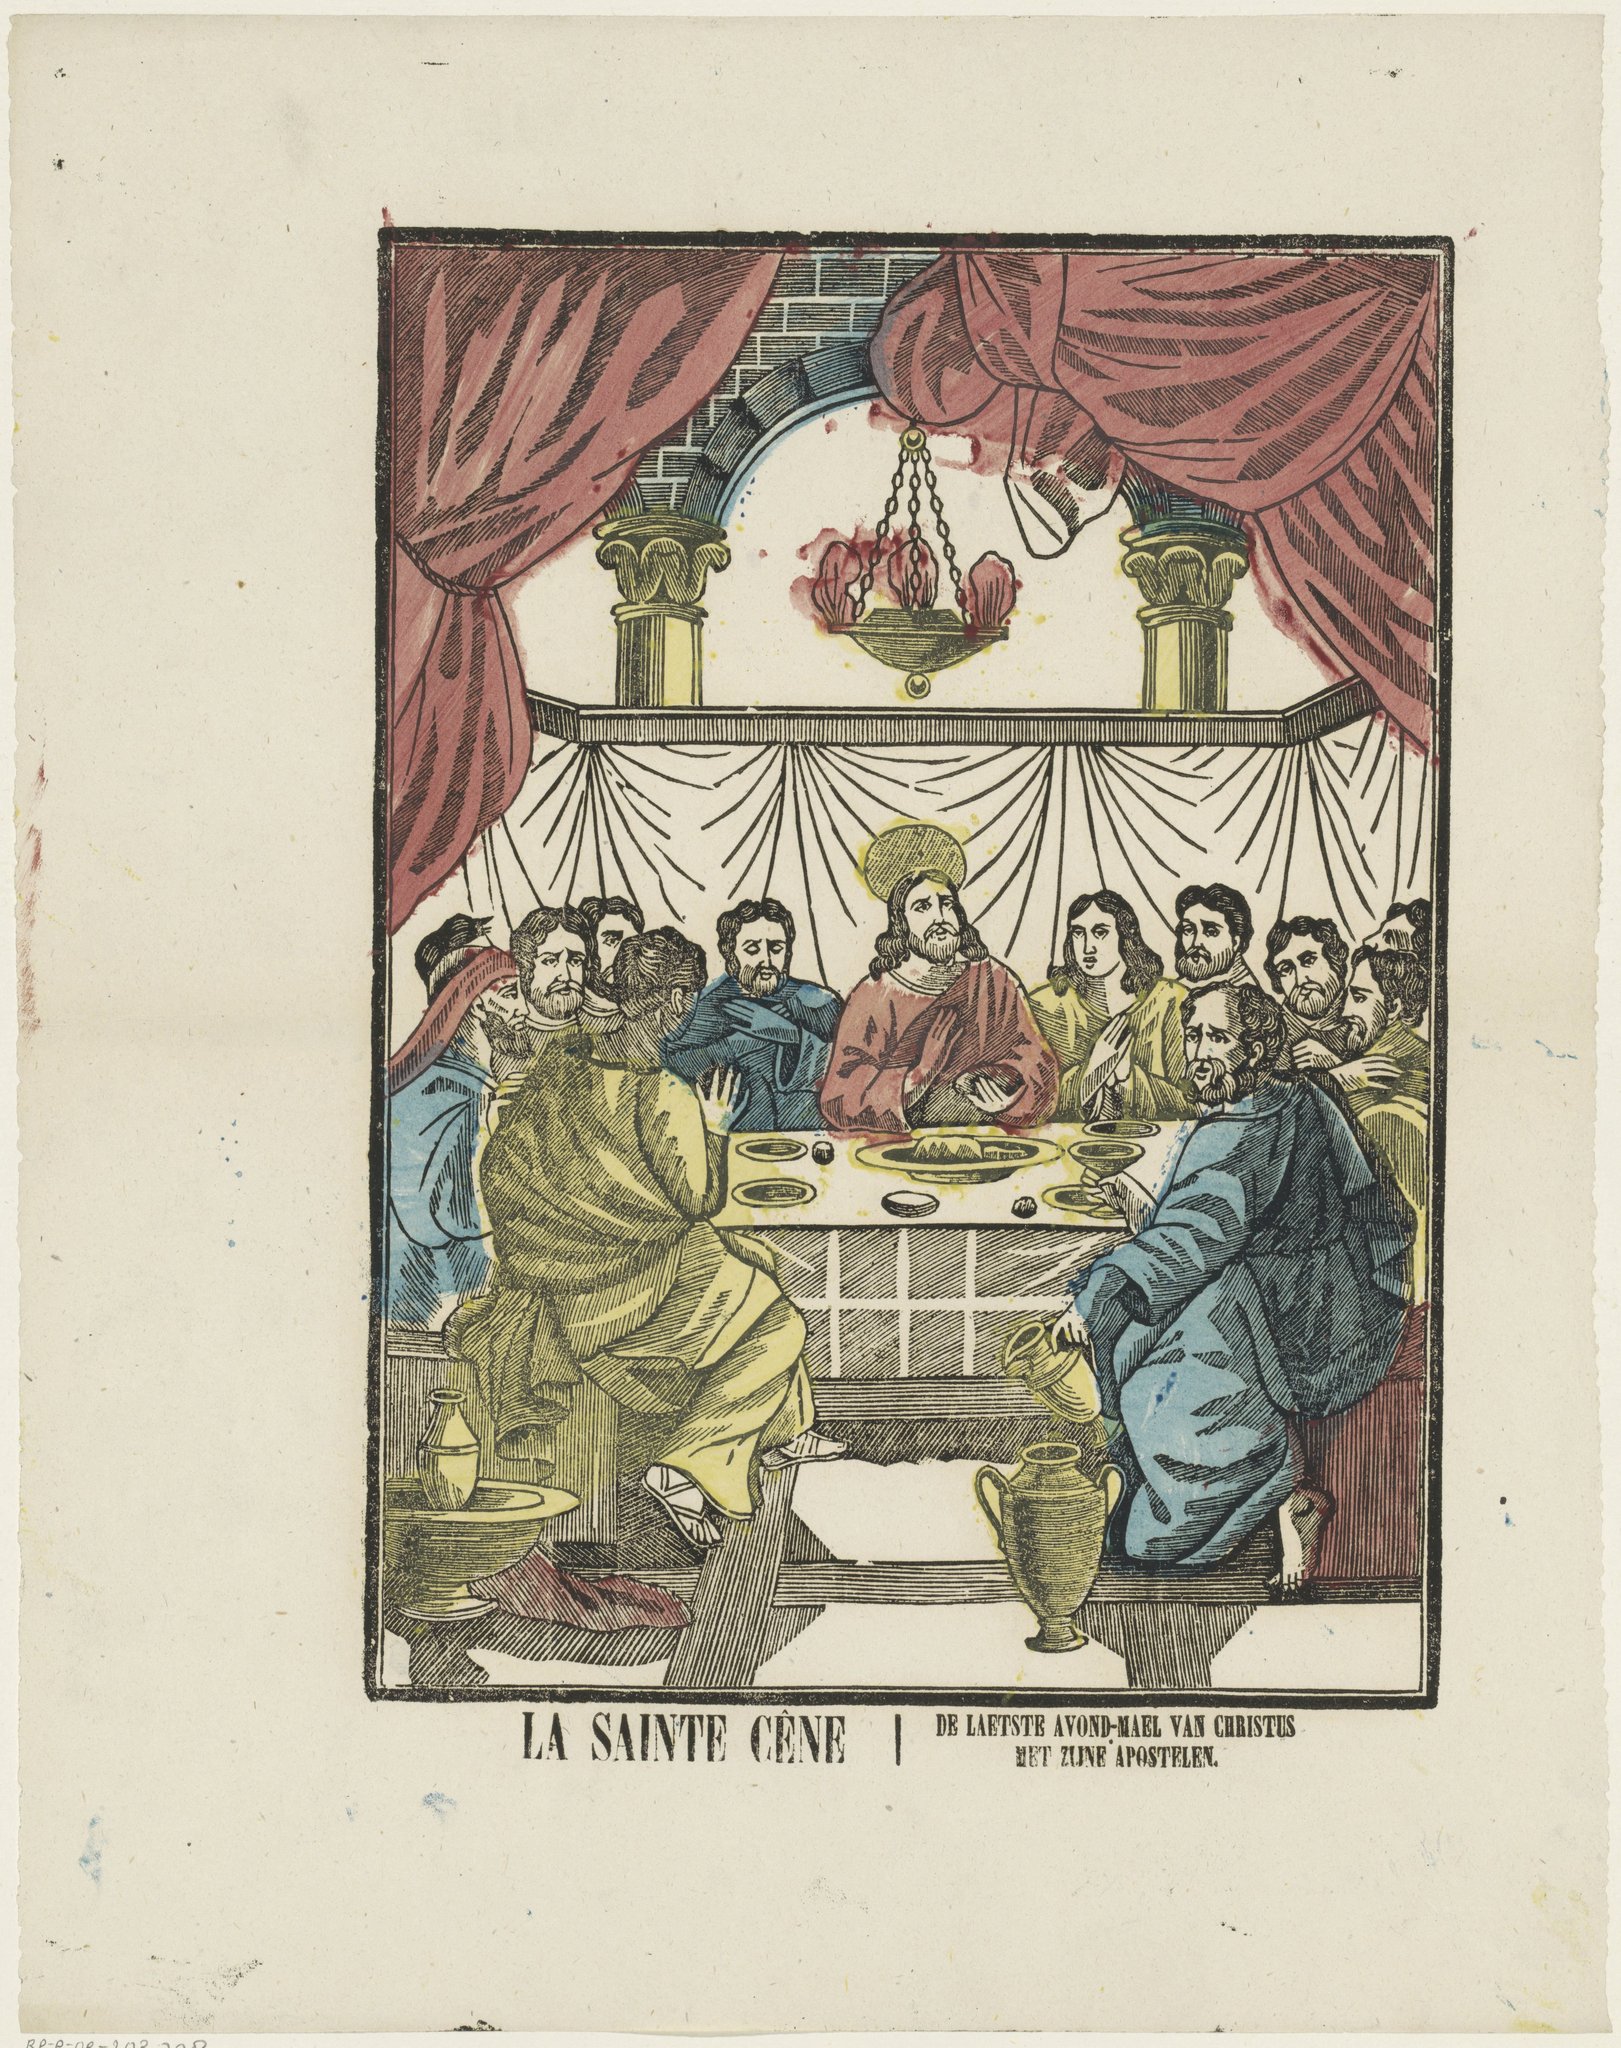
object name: popular print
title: La sainte cêne / De laetste avond-mael van Christus / met zijne apostelen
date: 1827-1894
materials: paper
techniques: colour, letterpress printing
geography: schaarbeek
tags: the episode of the last supper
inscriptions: collector's mark: Lugt 2760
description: Blad met een grote voorstelling van het Laatste Avondmaal. In de ondermarge de titel in het Nederlands en in het Frans.